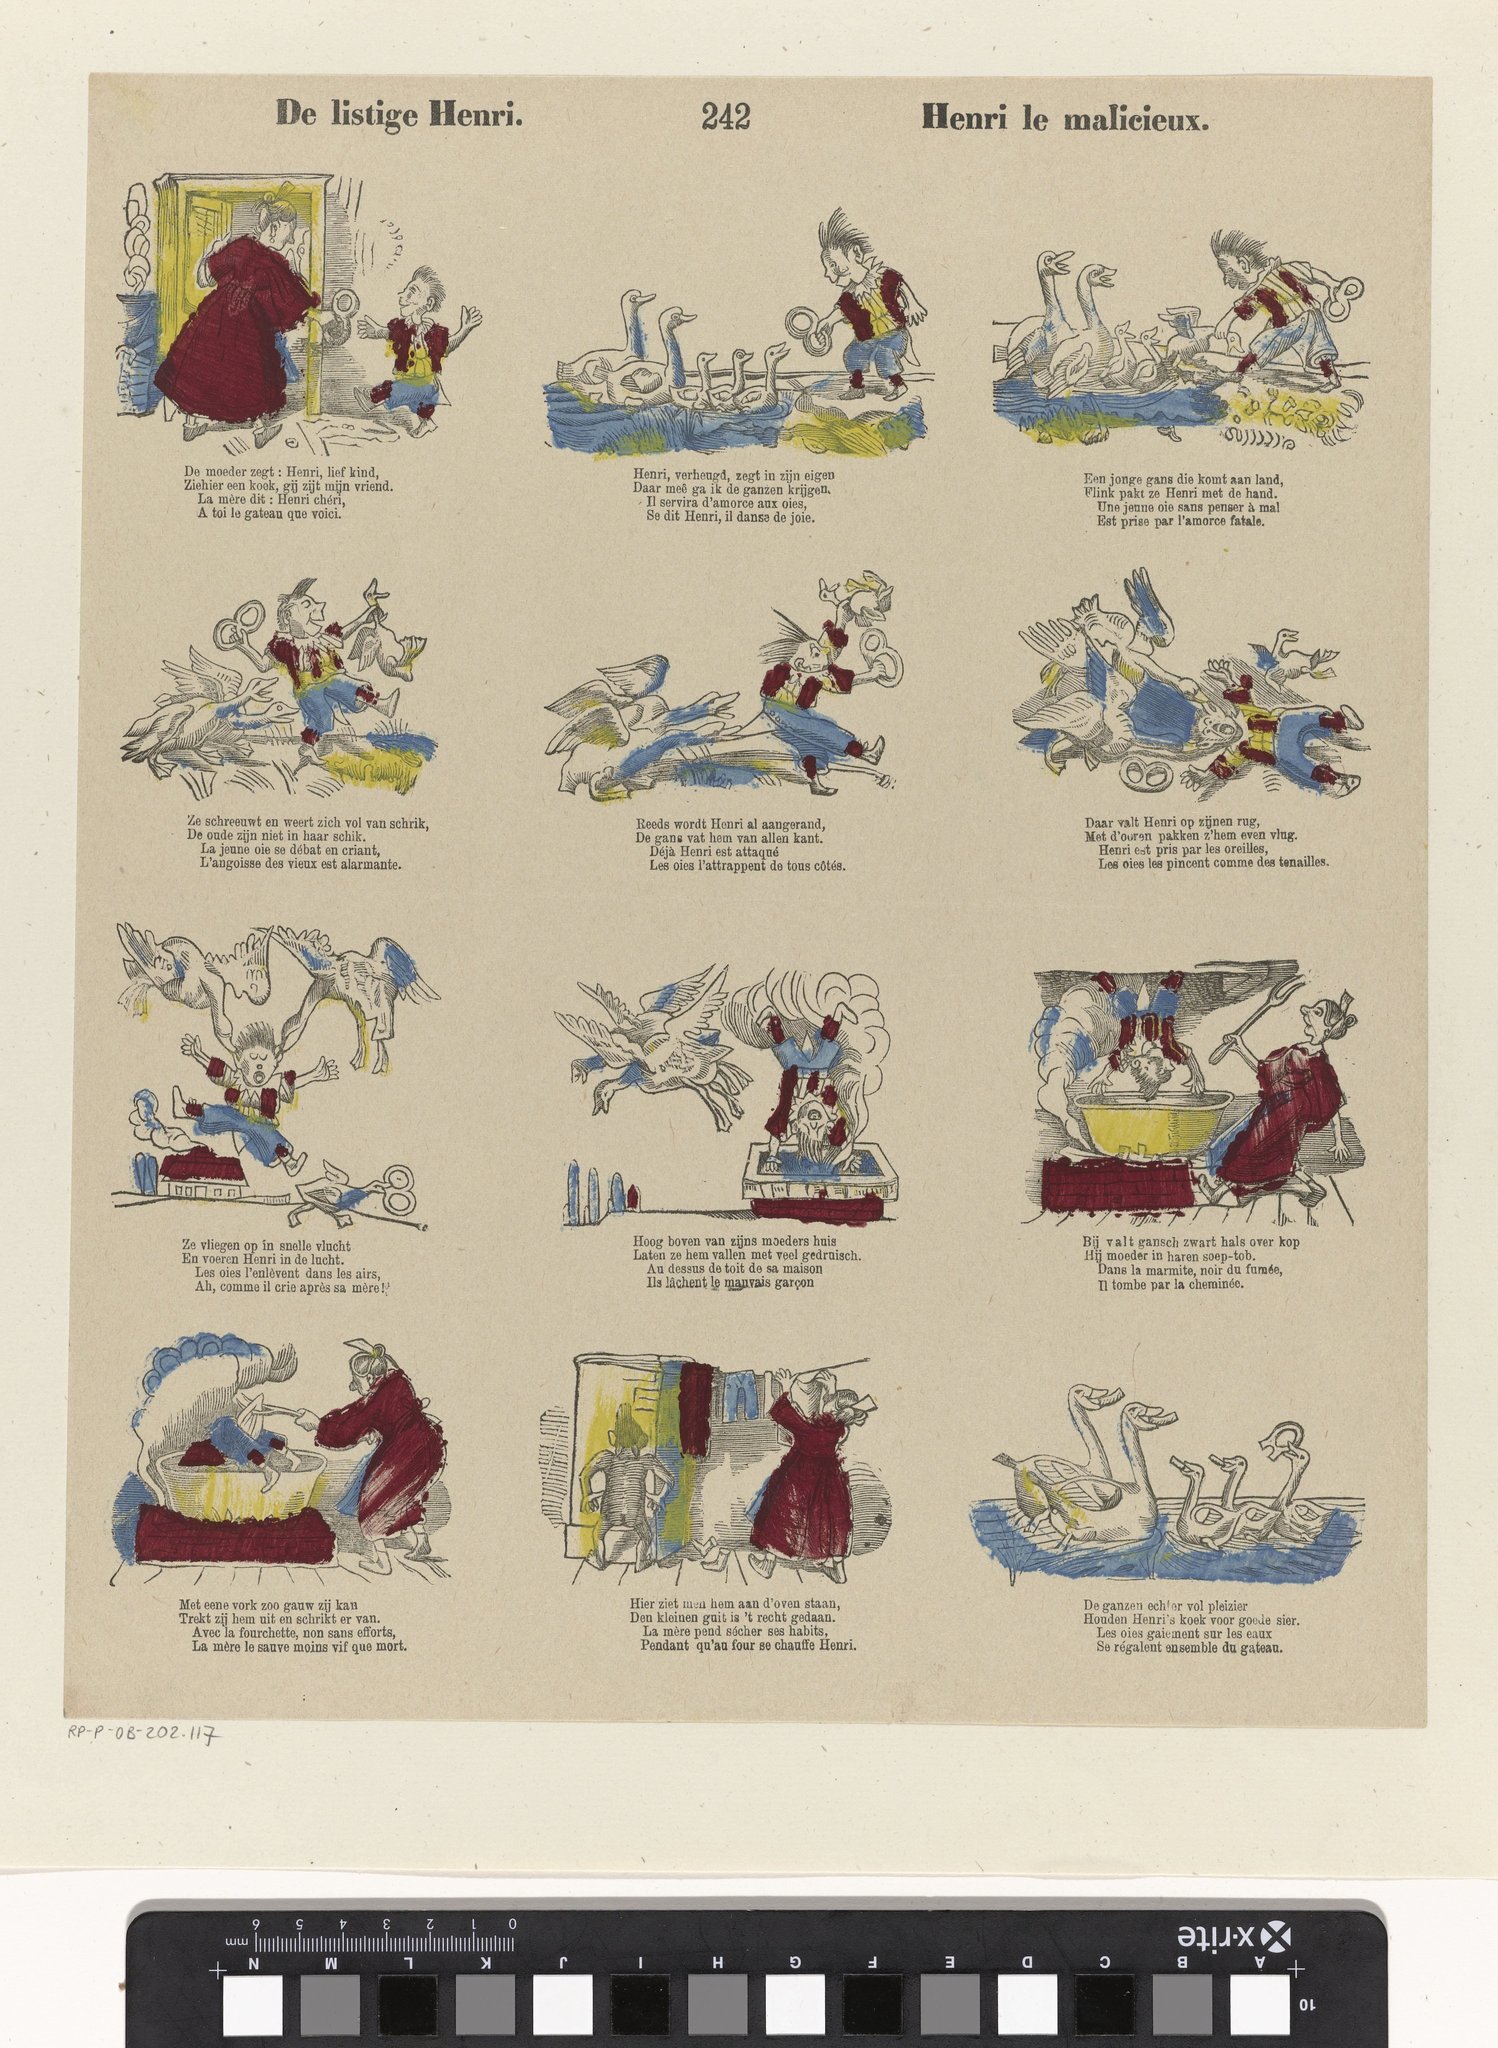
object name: print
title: De listige Hendrik / Henri le malicieux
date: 1800-1833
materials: paper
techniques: colour, letterpress printing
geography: turnhout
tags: correction of naughty children, water-birds: goose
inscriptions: collector's mark: Lugt 2760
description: Blad met 12 voorstellingen over Hendrik die de ganzen plaagt. De ganzen nemen hem als wraak mee op een luchtreis, waarna hij bij zijn moeder in een ketel met rijstebrij belandt. Onder elke afbeelding een onderschrift in het Nederlands en in het Frans. Genummerd midden boven: 242.